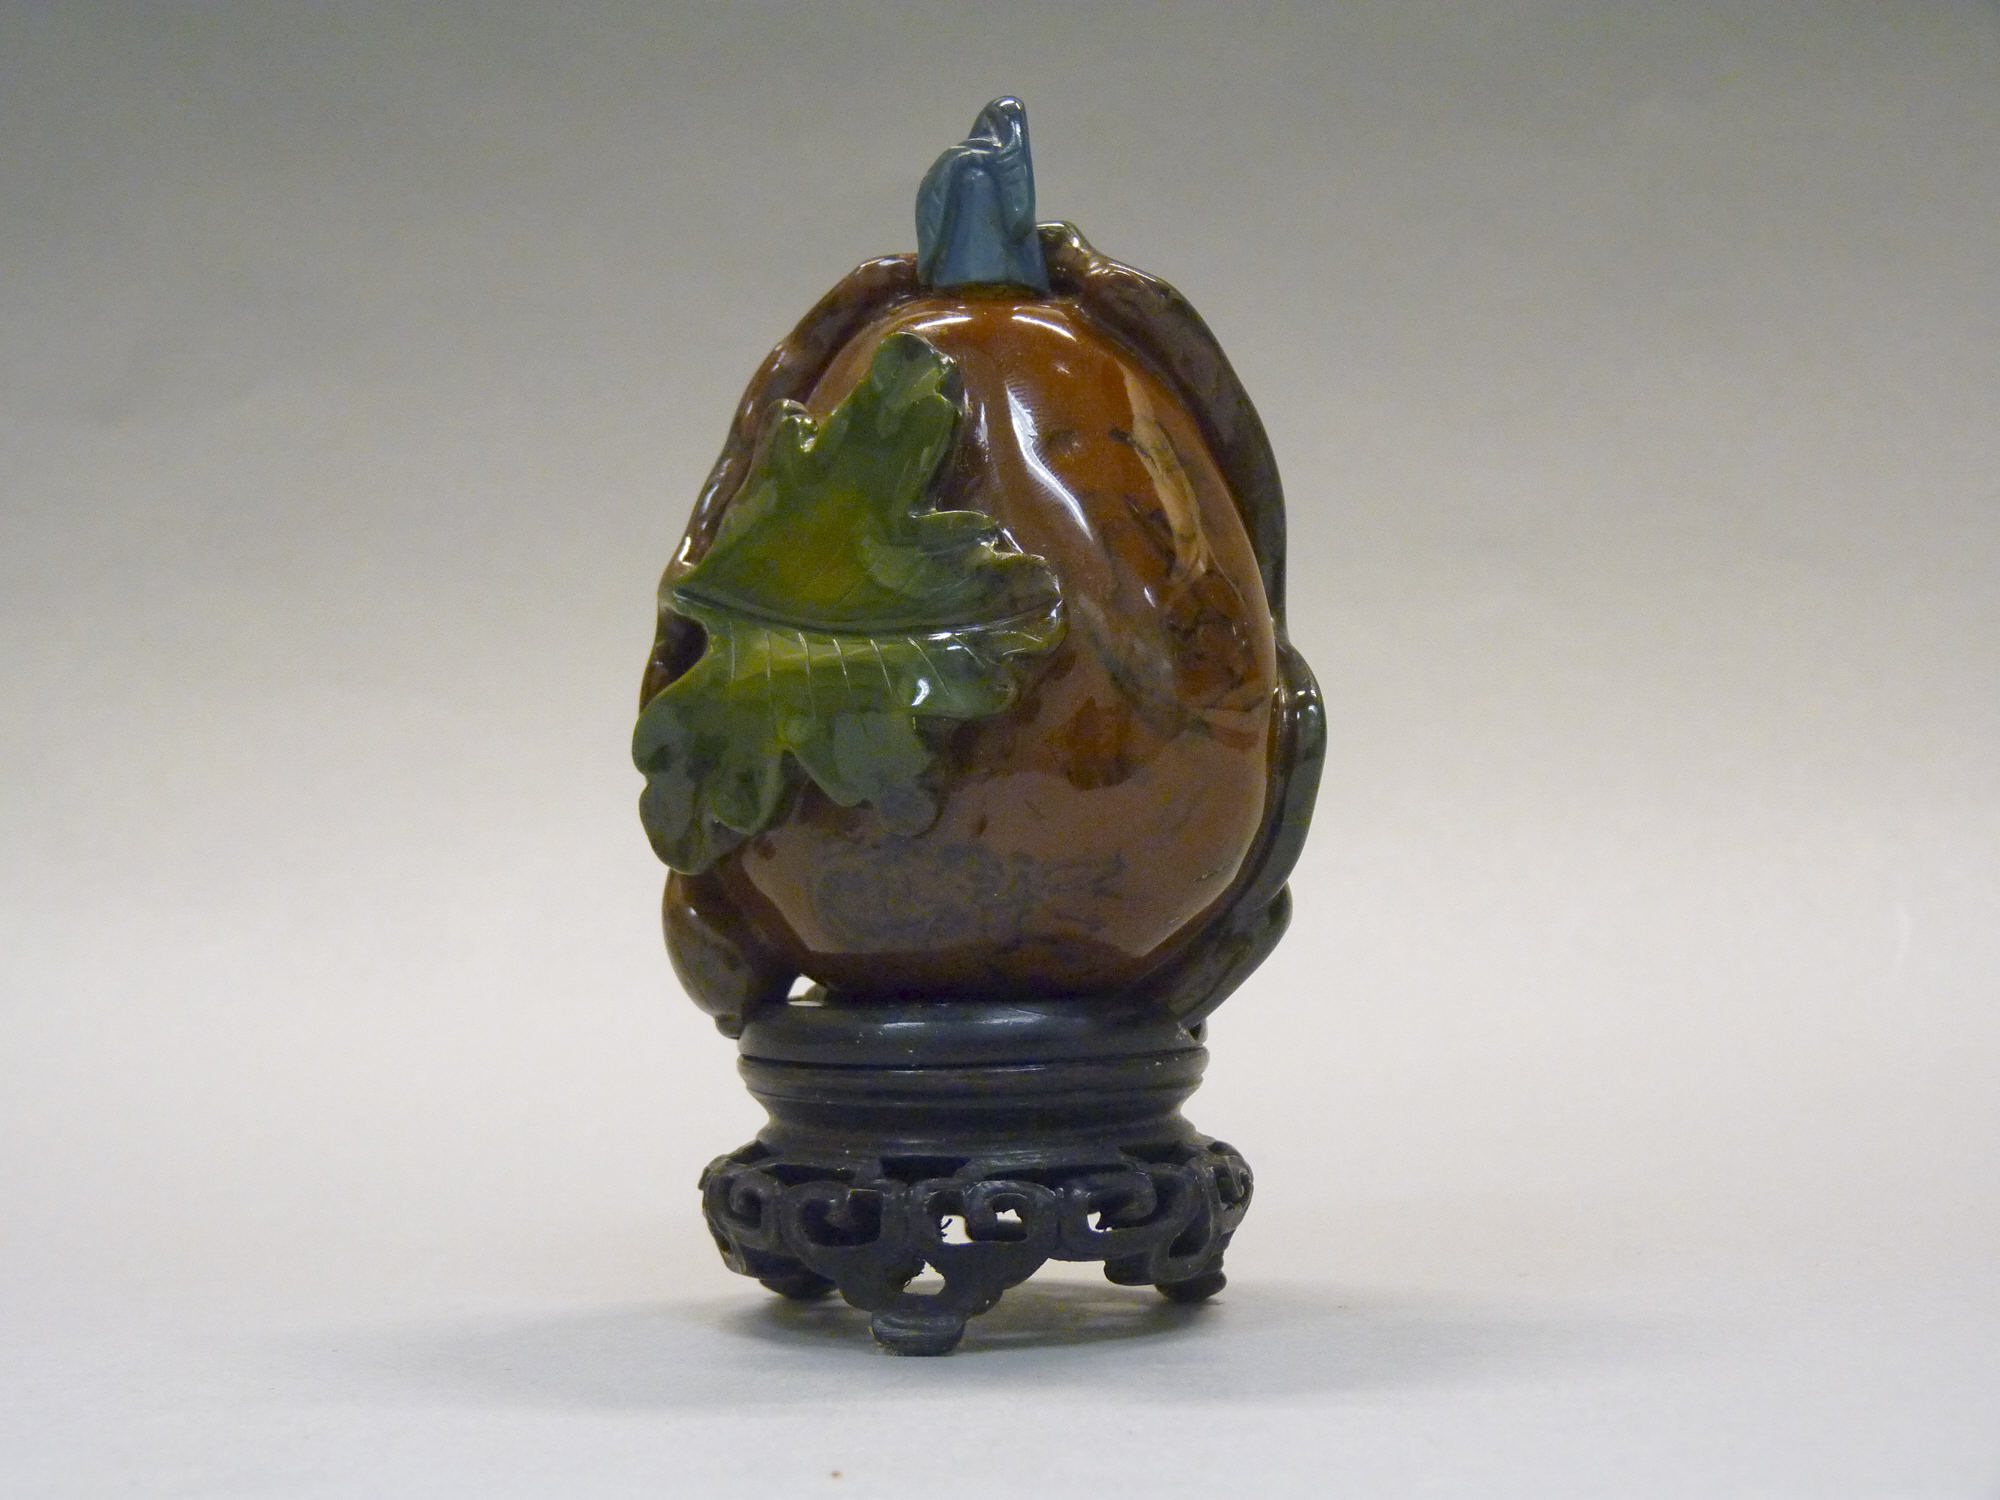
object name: snuff bottle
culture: chinese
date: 1736-1795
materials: glass, jasper, wood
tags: leaves